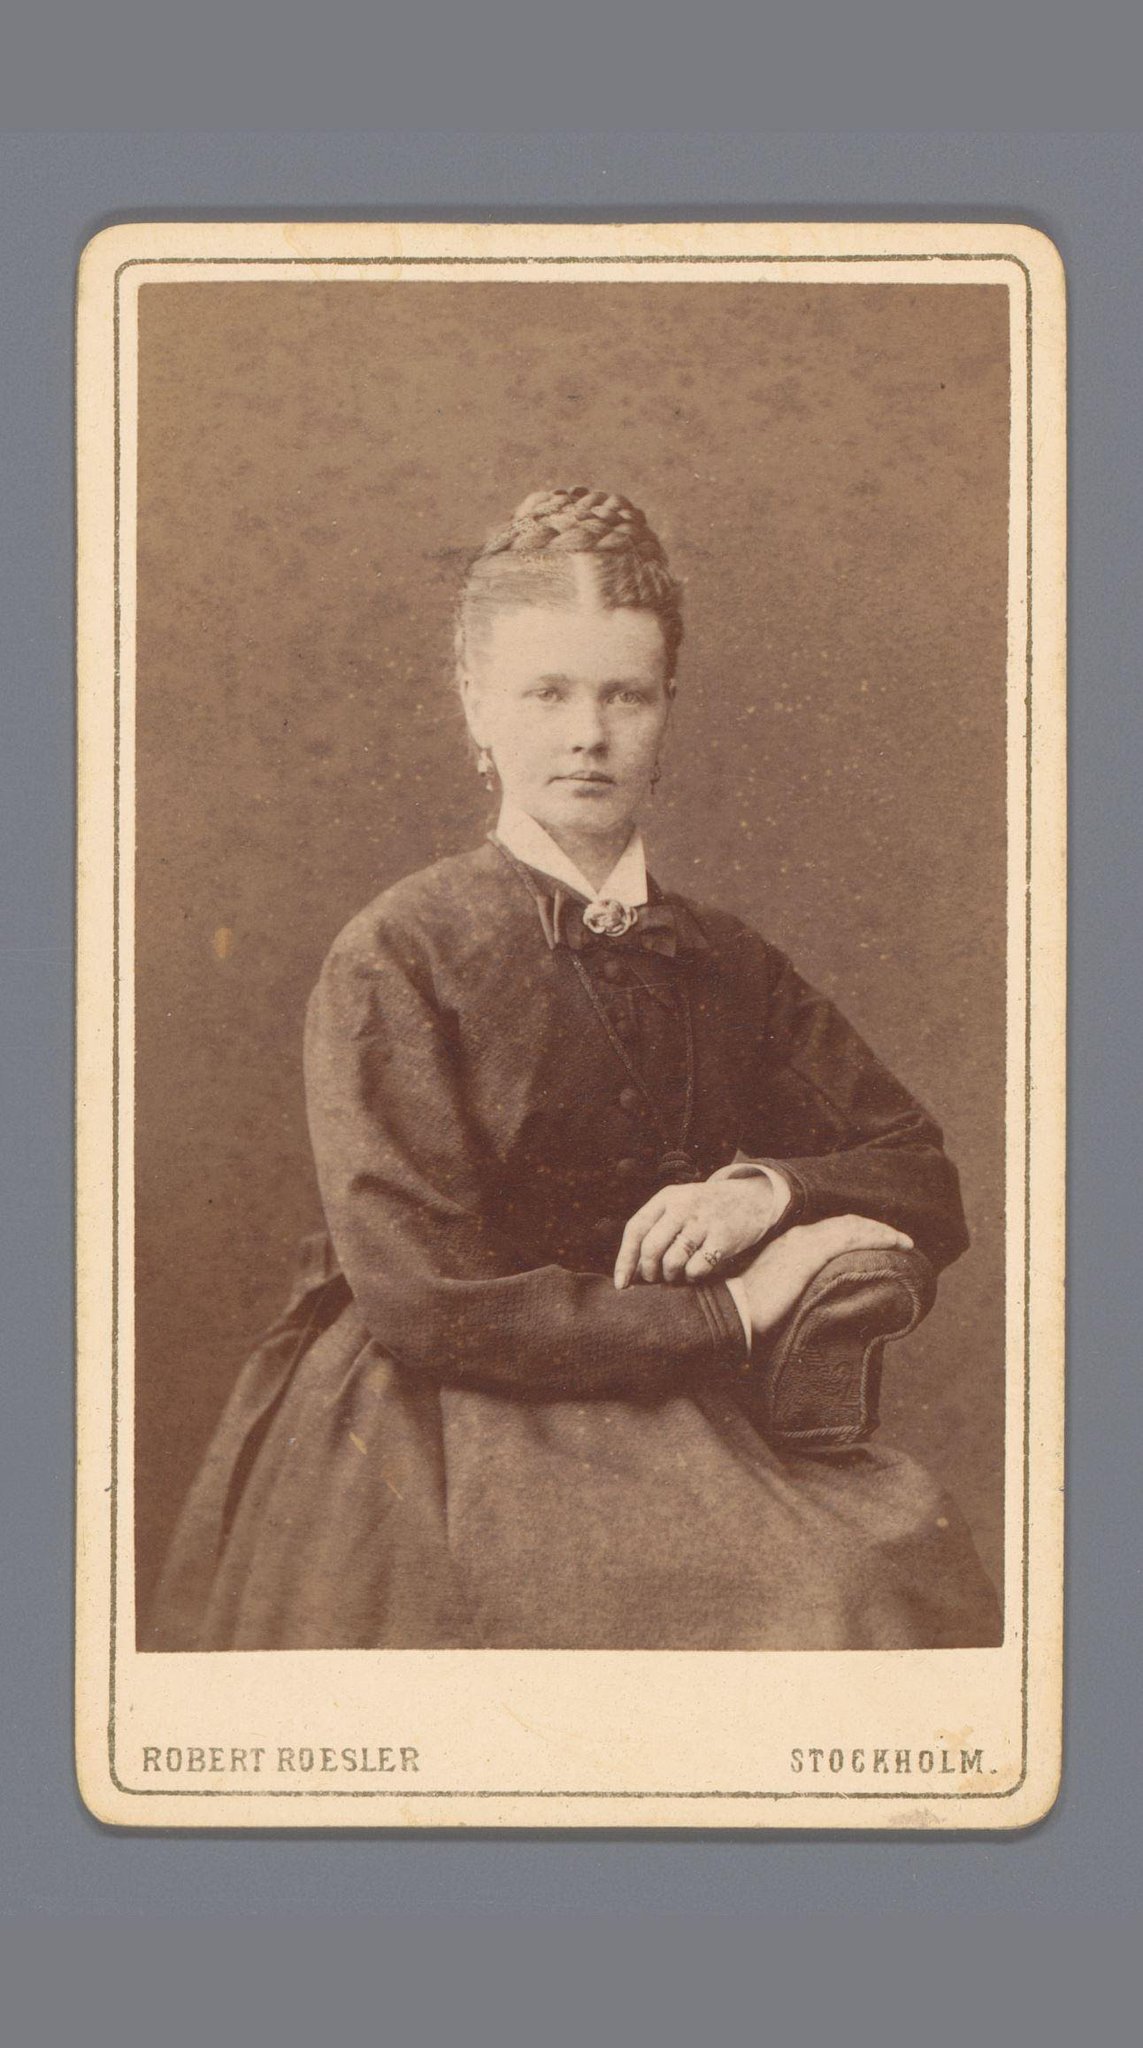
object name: photograph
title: Portret van een onbekende zittende vrouw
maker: august roesler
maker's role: fotograaf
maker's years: 1837-1896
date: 1870-1880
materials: cardboard, paper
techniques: albumen print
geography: stockholm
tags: sitting figure - aa - female human figure, historical persons - bb - woman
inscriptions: inscription: ‘Robert Roesler/ Fotografisk Atelier/ STOCKHOLM/ 38 Stora Nygatan 38/ Plåten förvaras för efterbeställning.’